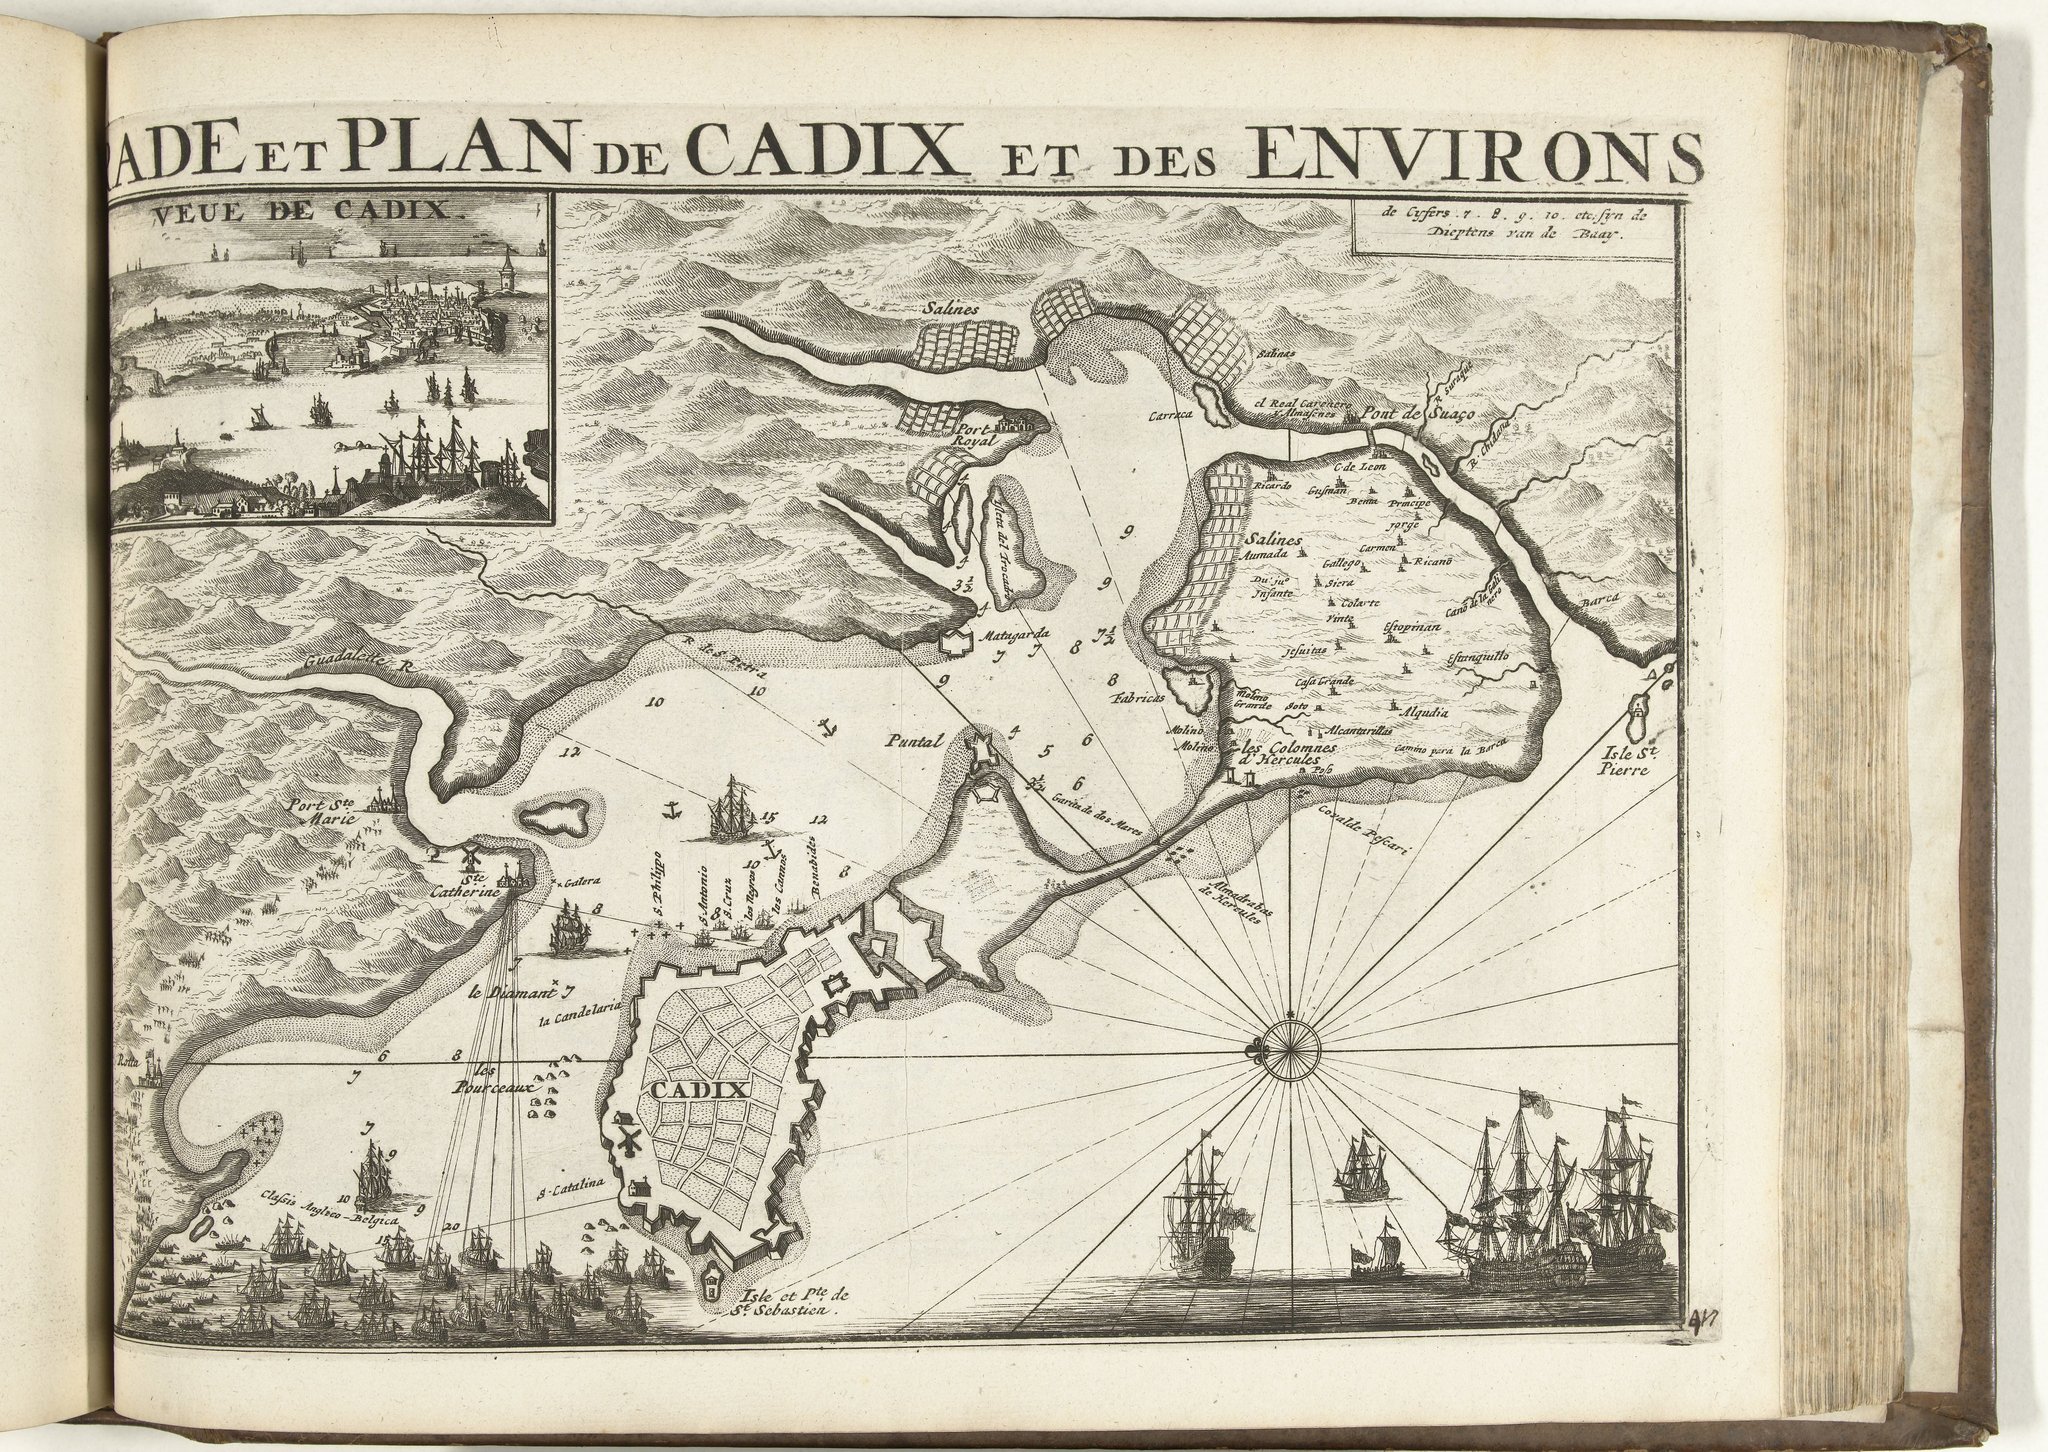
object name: map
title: Rade et Plan de Cadix et des Environs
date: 1726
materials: paper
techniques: etching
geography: northern netherlands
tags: maps of separate countries or regions, battle (+ land forces)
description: Kaart van Cadiz en omgeving, inzet met gezicht op Cadiz. Een Engels-Nederlandse vloot wordt door de Spanjaarden beschoten, onderaan gaan troepen bij Rota aan land, 26 augustus 1702. Plaat nr. 417 in deel XVII van het prentwerk: Les Forces de l'Europe, Asie, Afrique et Amerique ... Comme aussi les Cartes des Côtes de France et d'Espagne uit 1726, dit tweede deel met 271 met de hand genummerde platen van vermaarde sterke steden en vestingen in het kader van de Spaanse Successieoorlog 1701-1713. Voor het merendeel zijn deze platen gekopieerd naar de anonieme Franse platen van vermaarde sterke steden en vestingen: in Les forces de l'Europe en in: Le theatre de la guerre, dans les Pays-Bas, beide oorspronkelijk uitgegeven door Nicolas de Fer te Parijs (1693-1697) in het kader van de Negenjarige Oorlog. Titel en opschriften in het Frans.